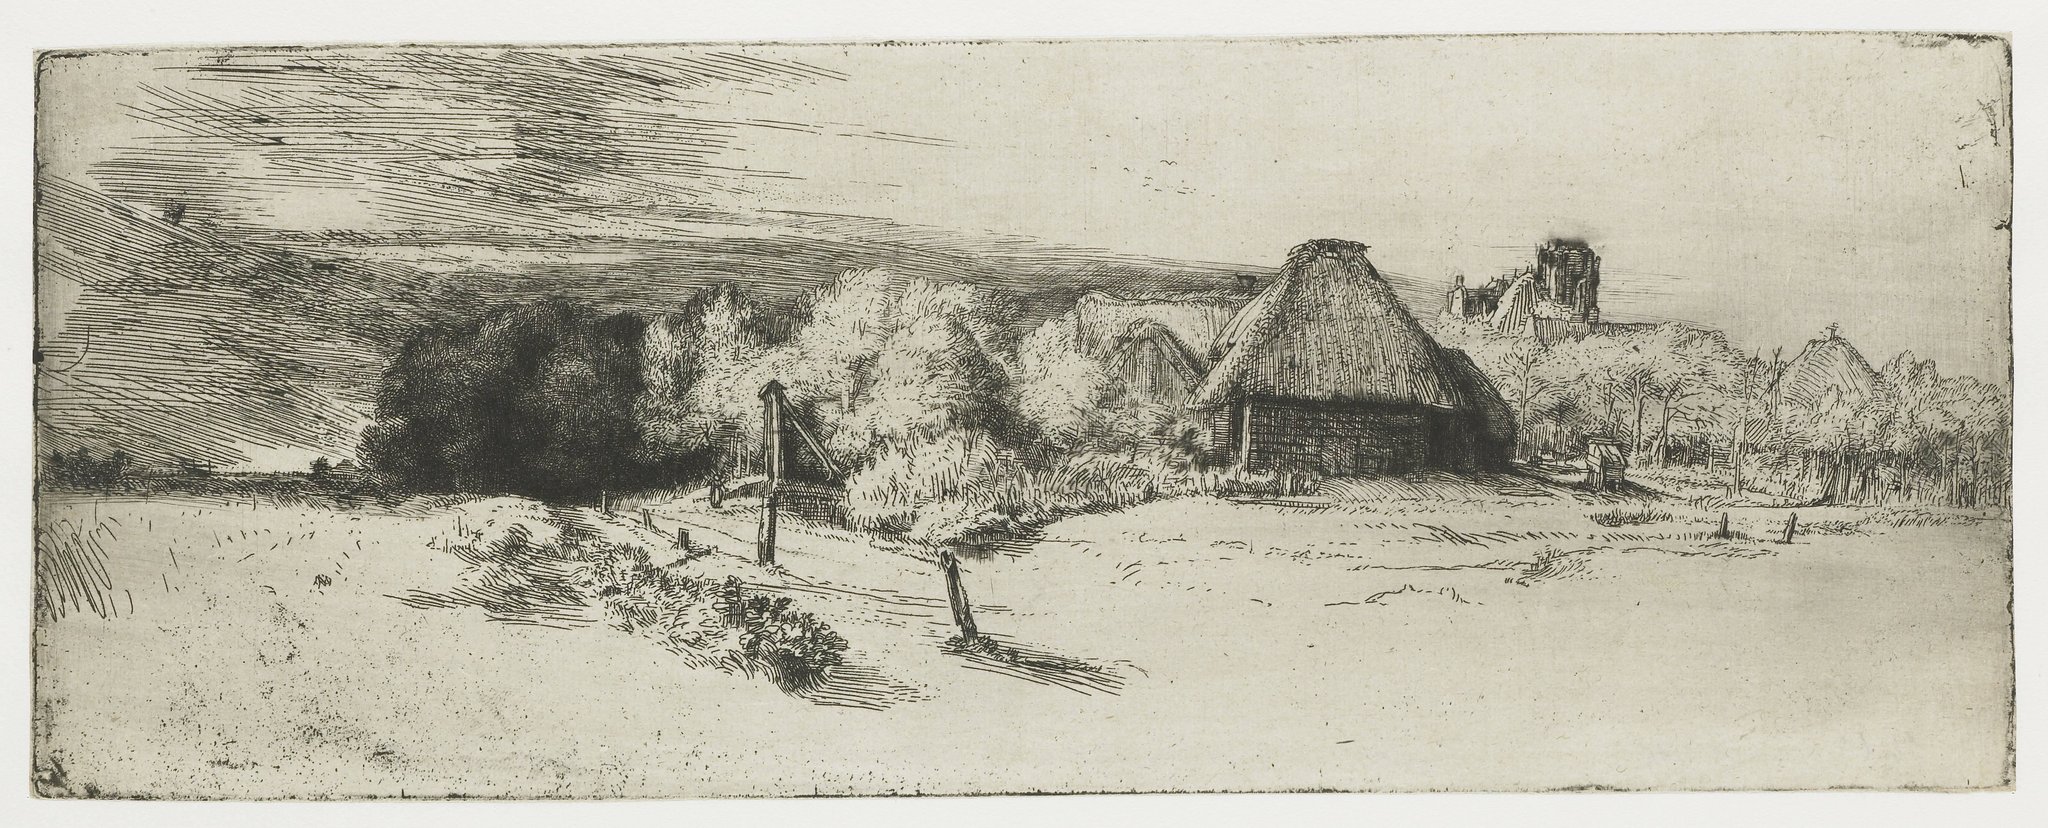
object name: print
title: Landscape with a farm building and the 'house with the tower'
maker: rembrandt van rijn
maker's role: draughtsman, painter, print maker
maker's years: 1606-1669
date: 1650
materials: paper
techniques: drypoint, etching, intaglio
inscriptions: mark: ‘Libert de Beaumont 1784’ Lugt 1679, mark: Lugt 2228, mark: Lugt 1257 e